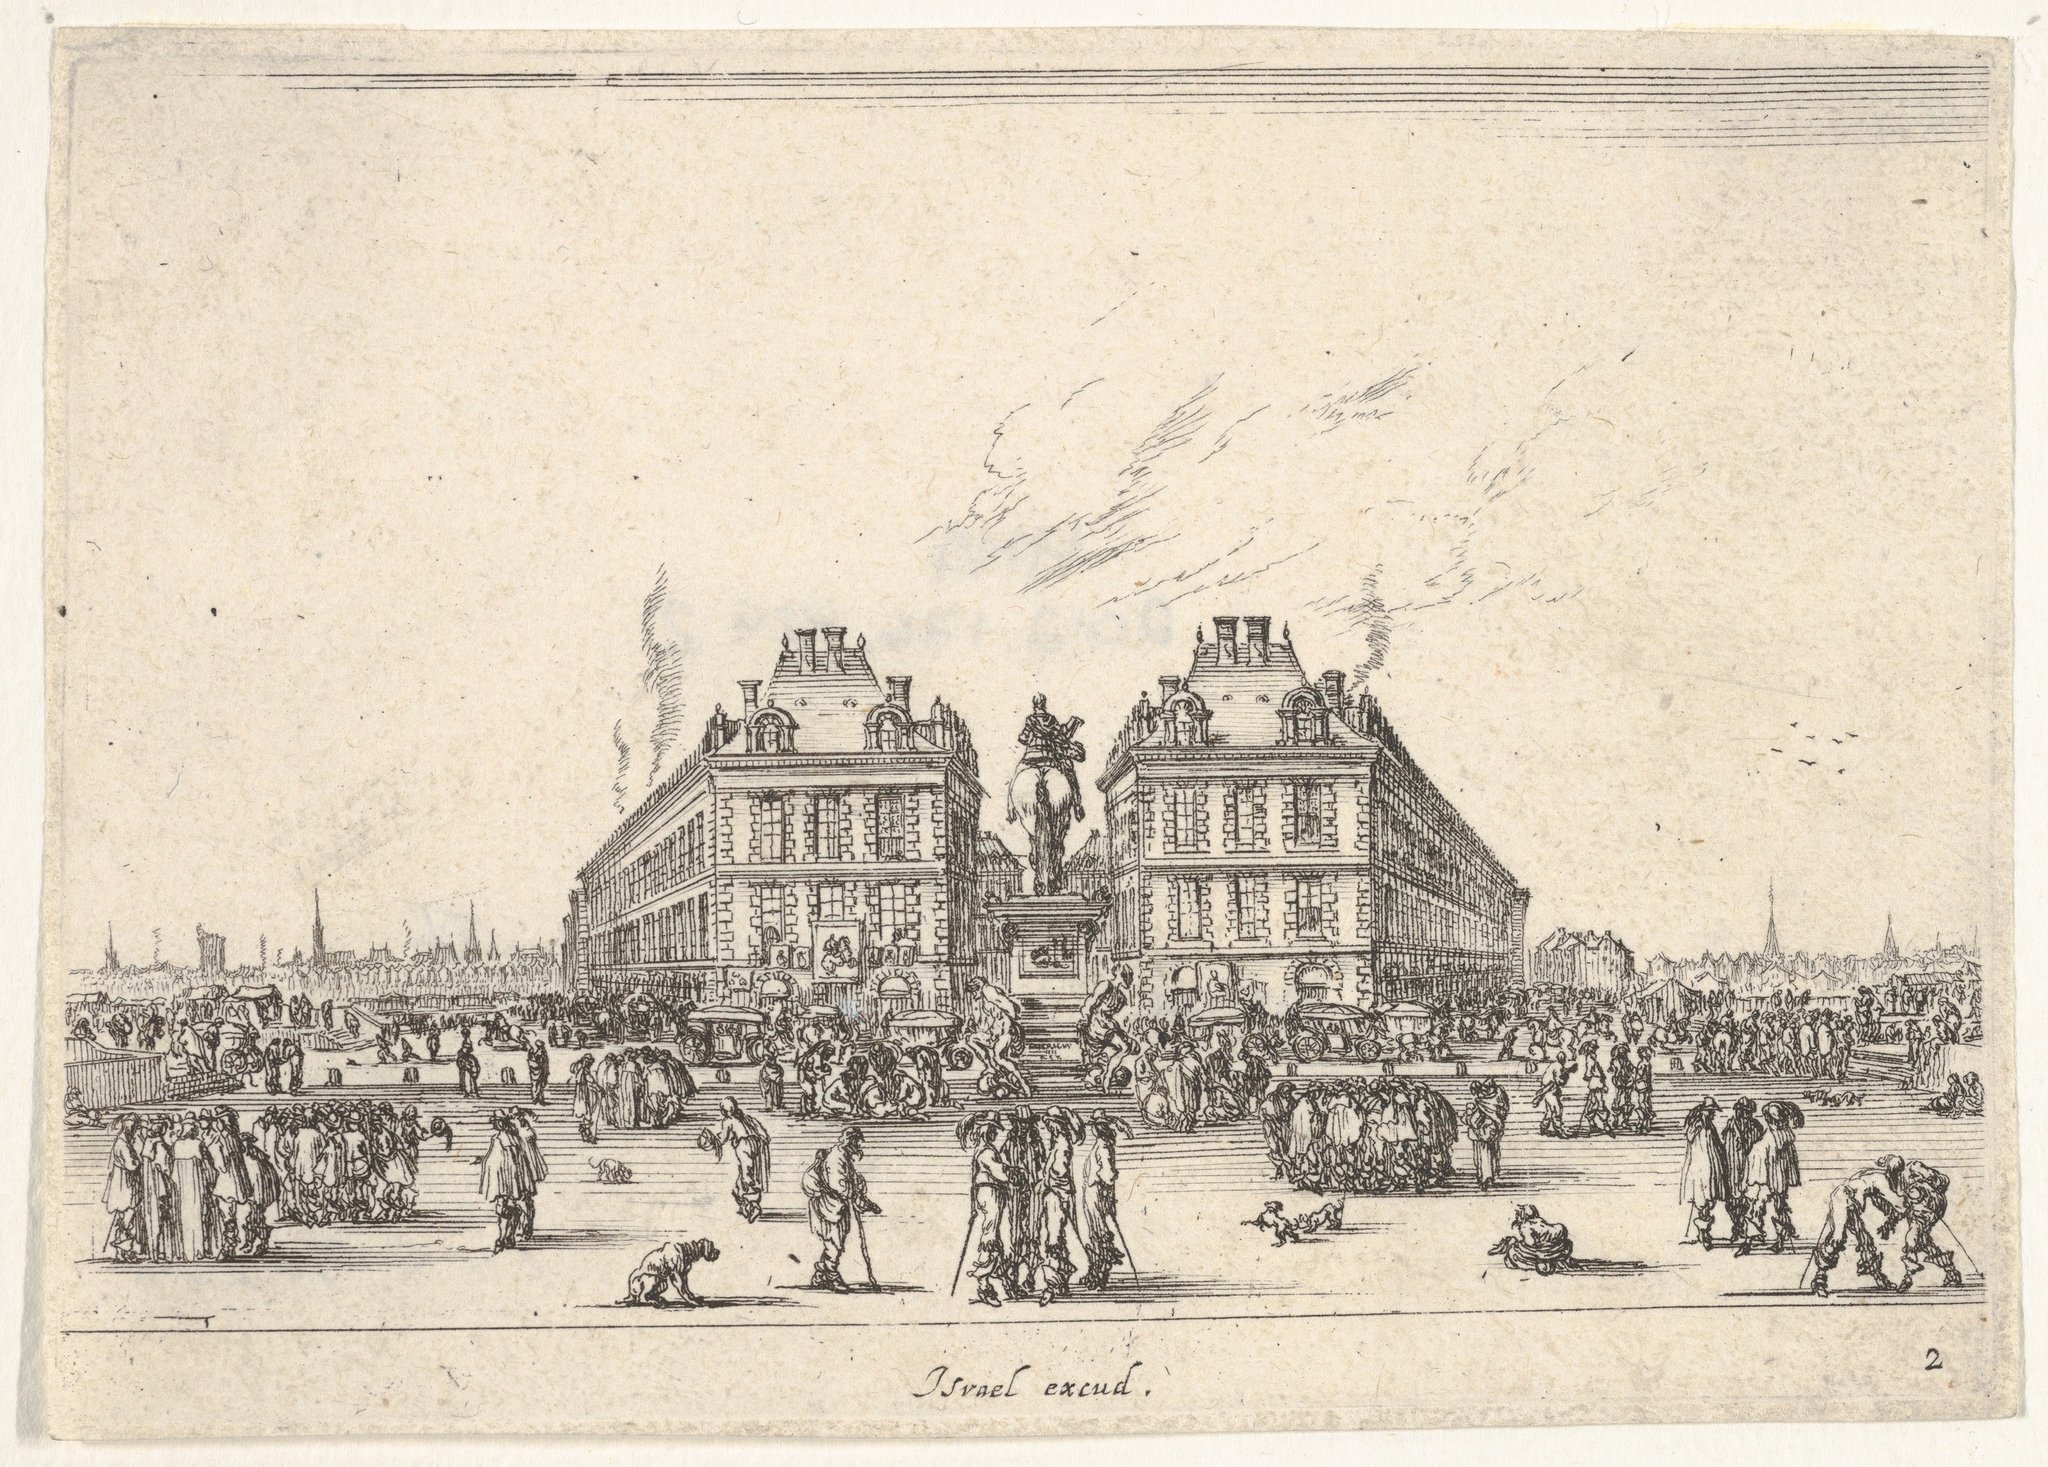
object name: print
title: Plate 2: La Place Dauphine, on the coast of Pont Neuf, the equestrian statue of Louis XIII in center, seen from the back and numerous figures, from "Various Figures" (Agréable diversité de figures)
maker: stefano della bella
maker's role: artist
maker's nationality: italian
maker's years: 1610-1664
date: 1642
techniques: etching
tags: buildings,crowd